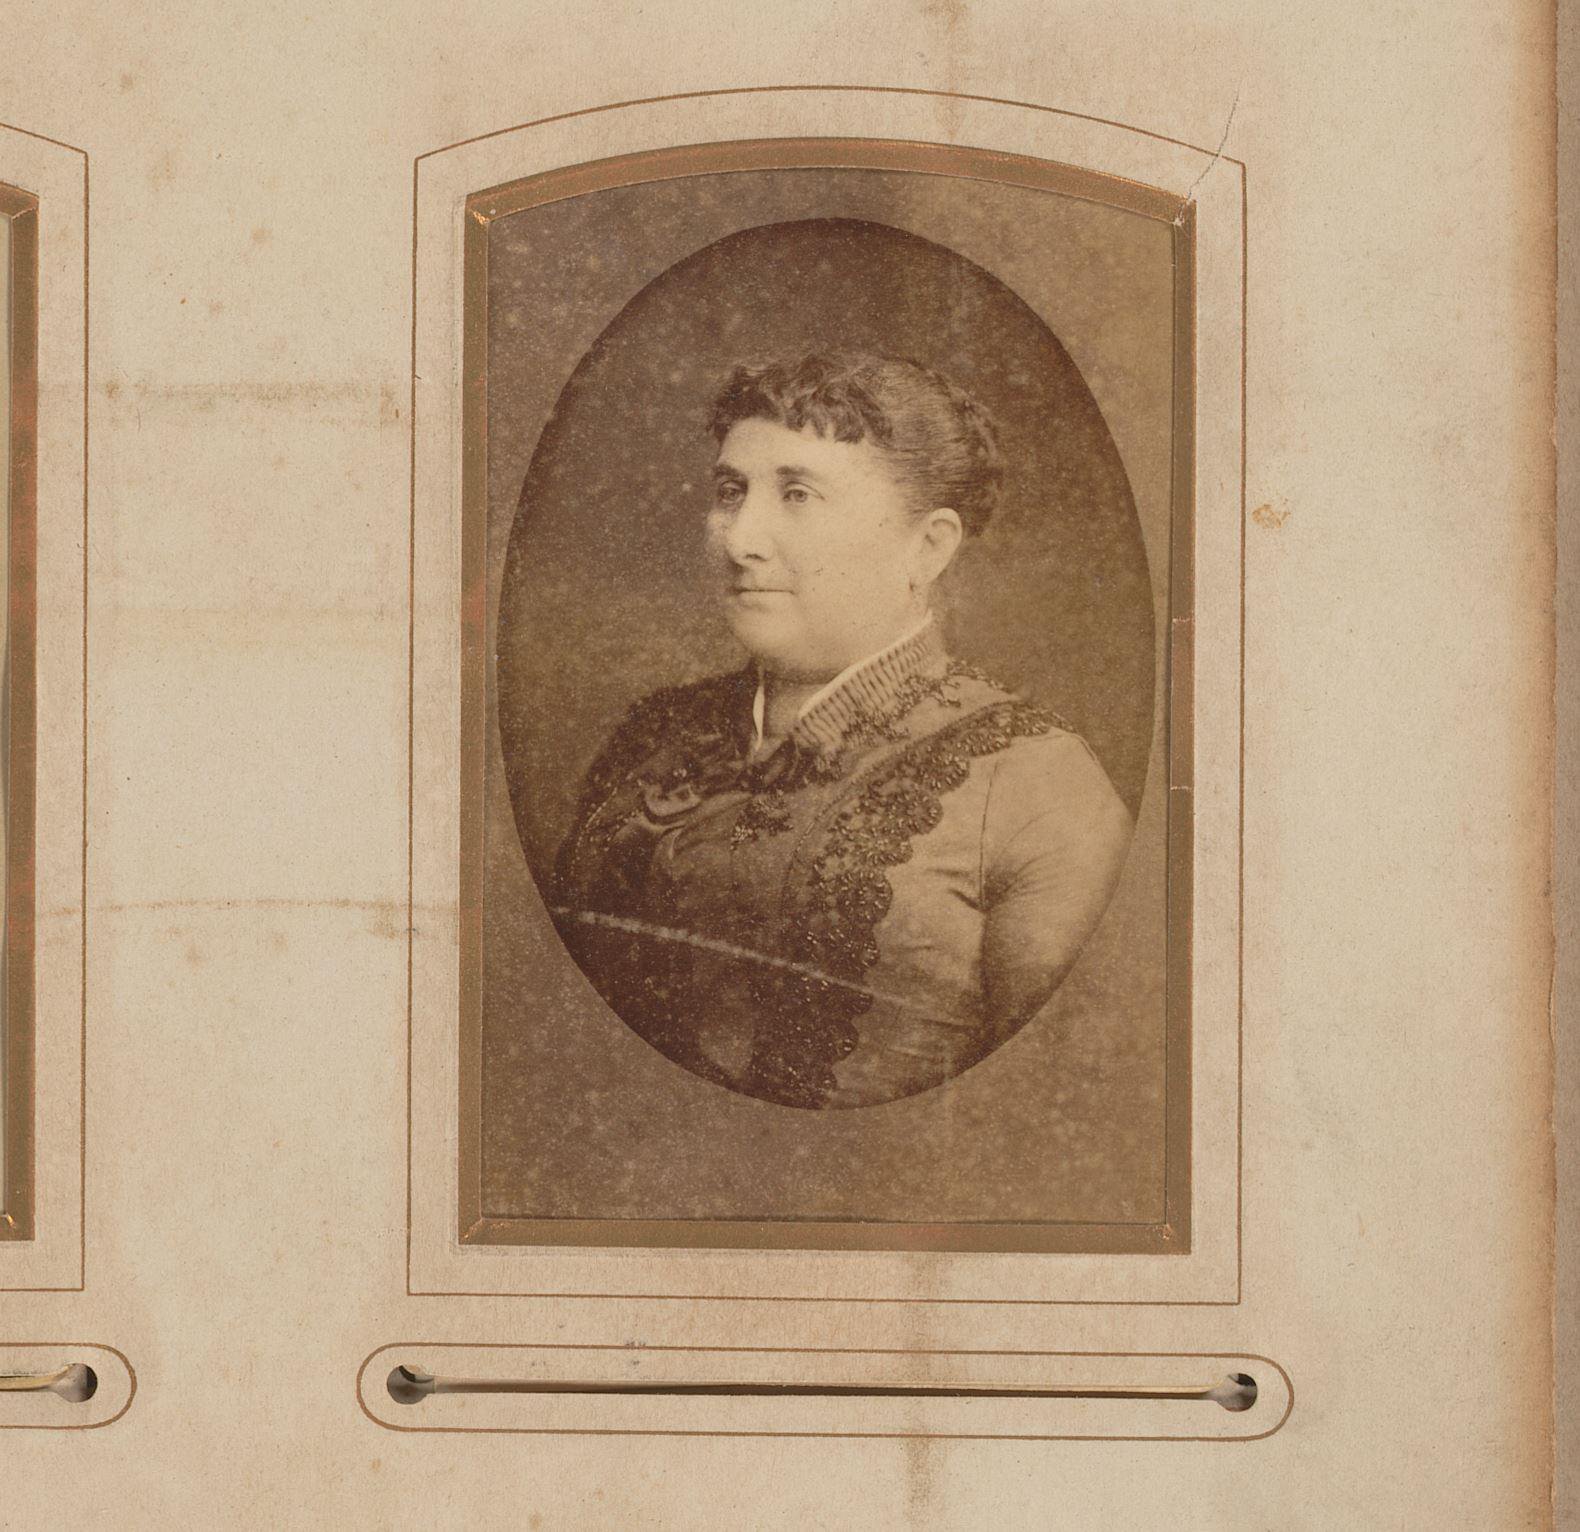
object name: album leaf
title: Portret van een vrouw in jurk met borduursels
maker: herman salzwedel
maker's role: fotograaf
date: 1880-1905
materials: cardboard, photographic support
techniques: albumen print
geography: surabaya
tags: historical persons - bb - woman, embroidery (ornamentation)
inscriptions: inscription: ‘(...)/ ATELIER/ van/ H. SALZWEDEL/ SOERABAYA/ JAVA./ Het cliché blijft voor nabestelling bewaard.’